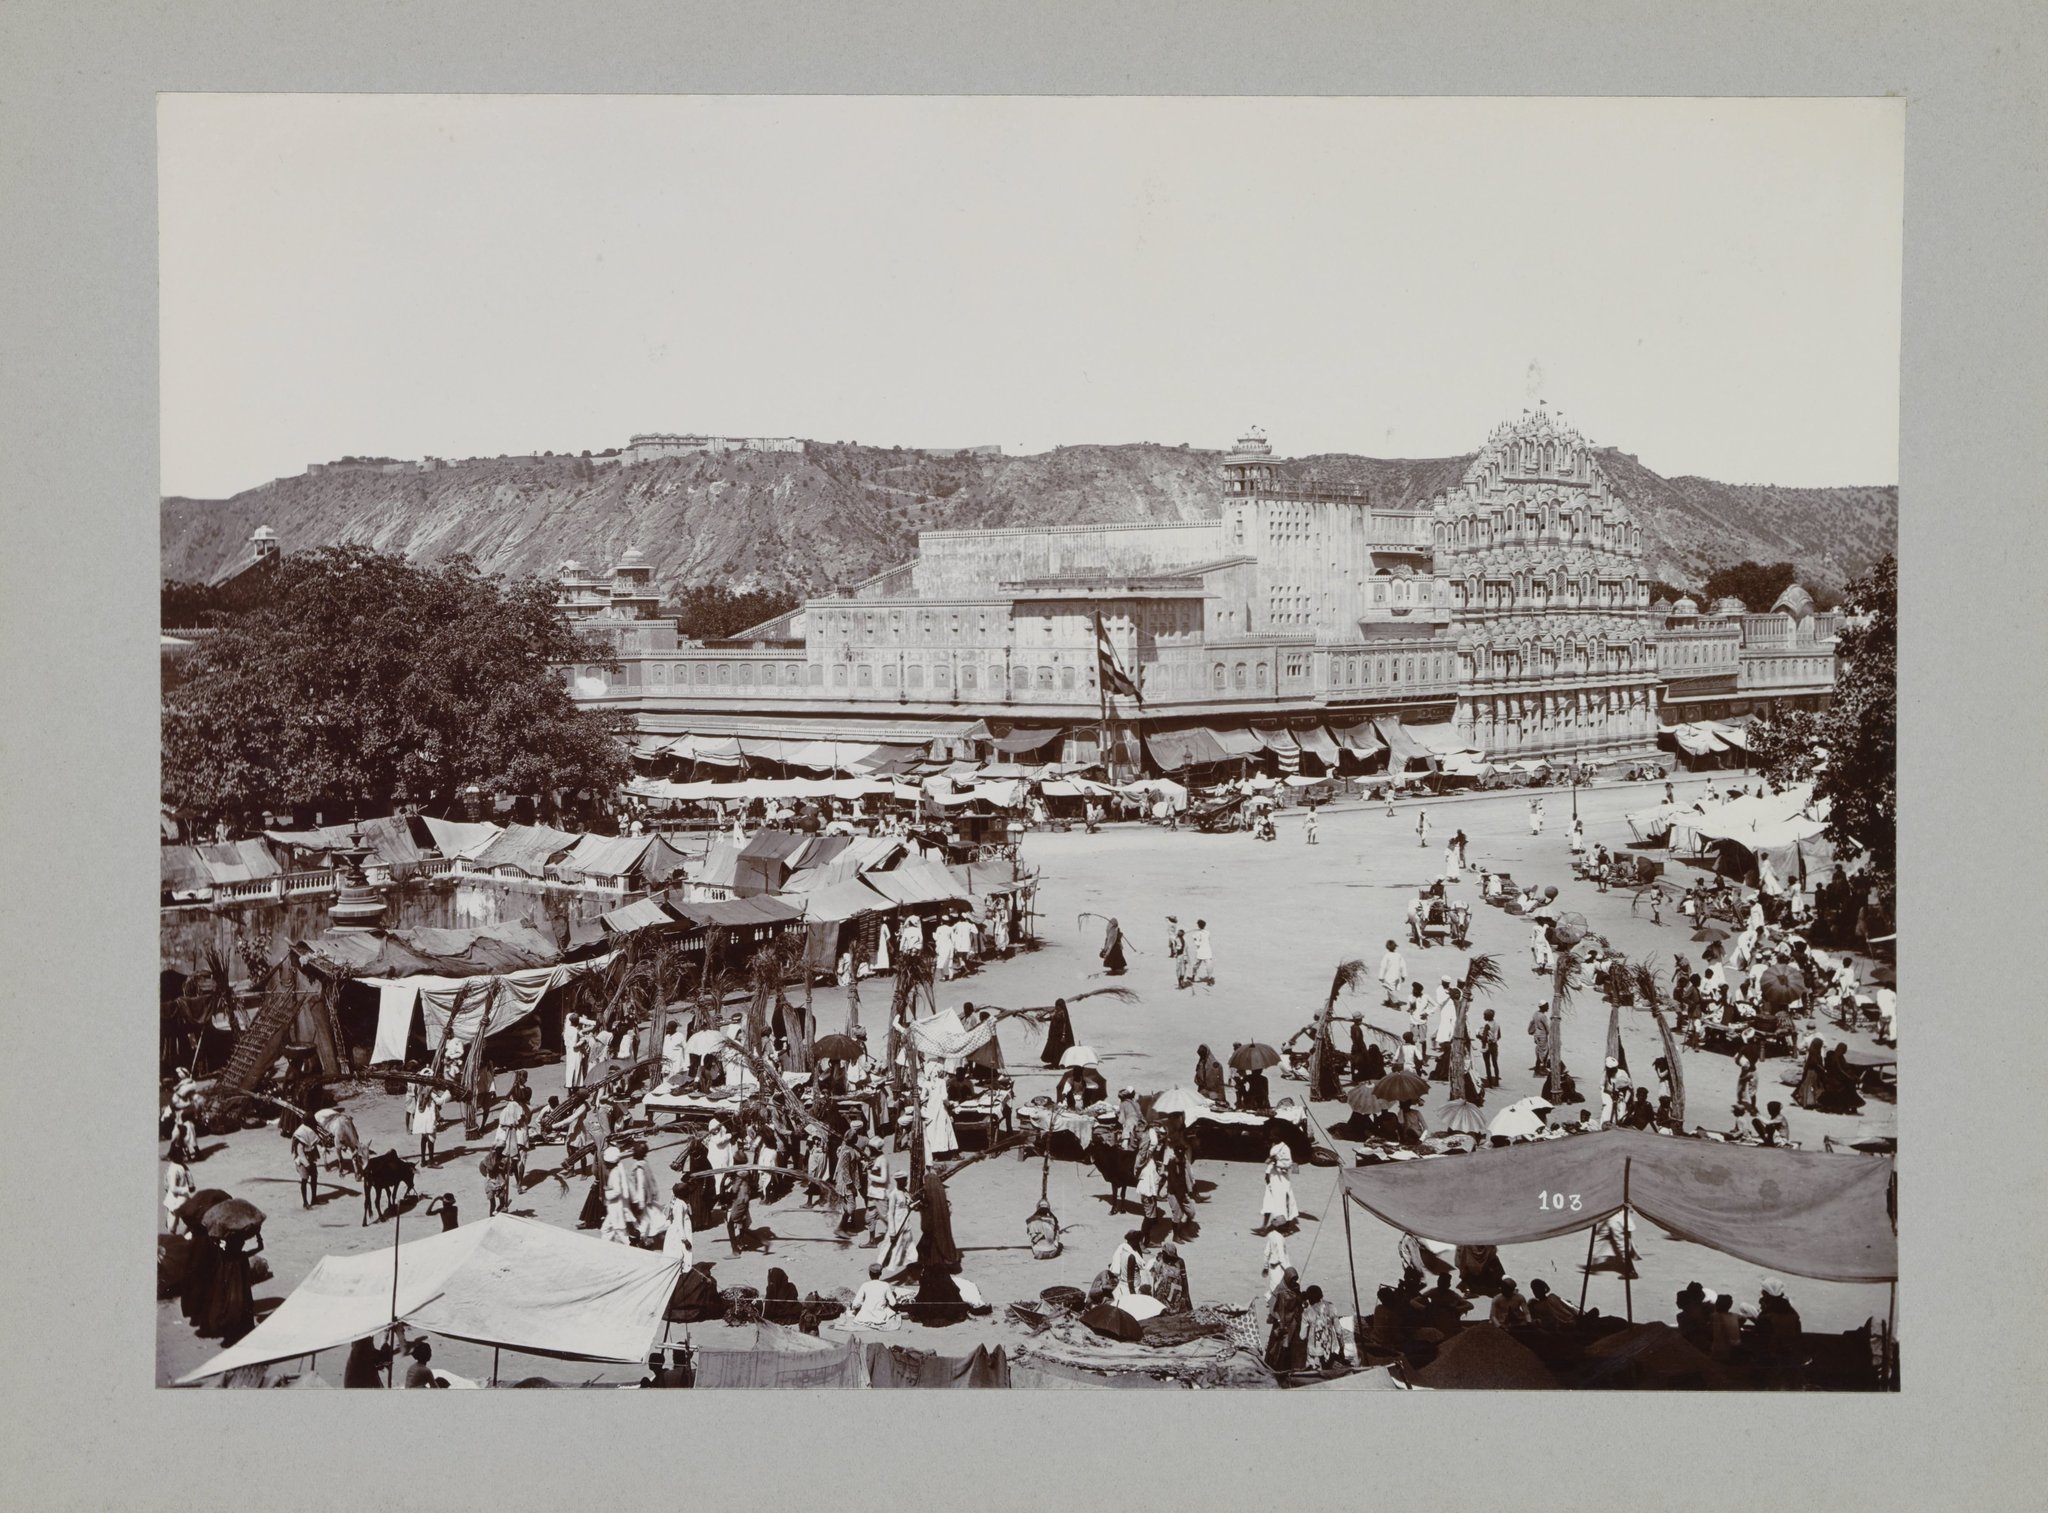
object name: photograph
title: Street view with Hawa Mahal in Jaipur, Rajasthan, India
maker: Anonymous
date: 1895-1915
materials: cardboard, paper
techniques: gelatin silver print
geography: jaipur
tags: hawa mahal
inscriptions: number: ‘103’, annotation: ‘67. Jaipur met 't huis der Winden.’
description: Uitzicht op Jaipur met rechtsboven in het midden het Paleis der Winden (Hawa Mahal).